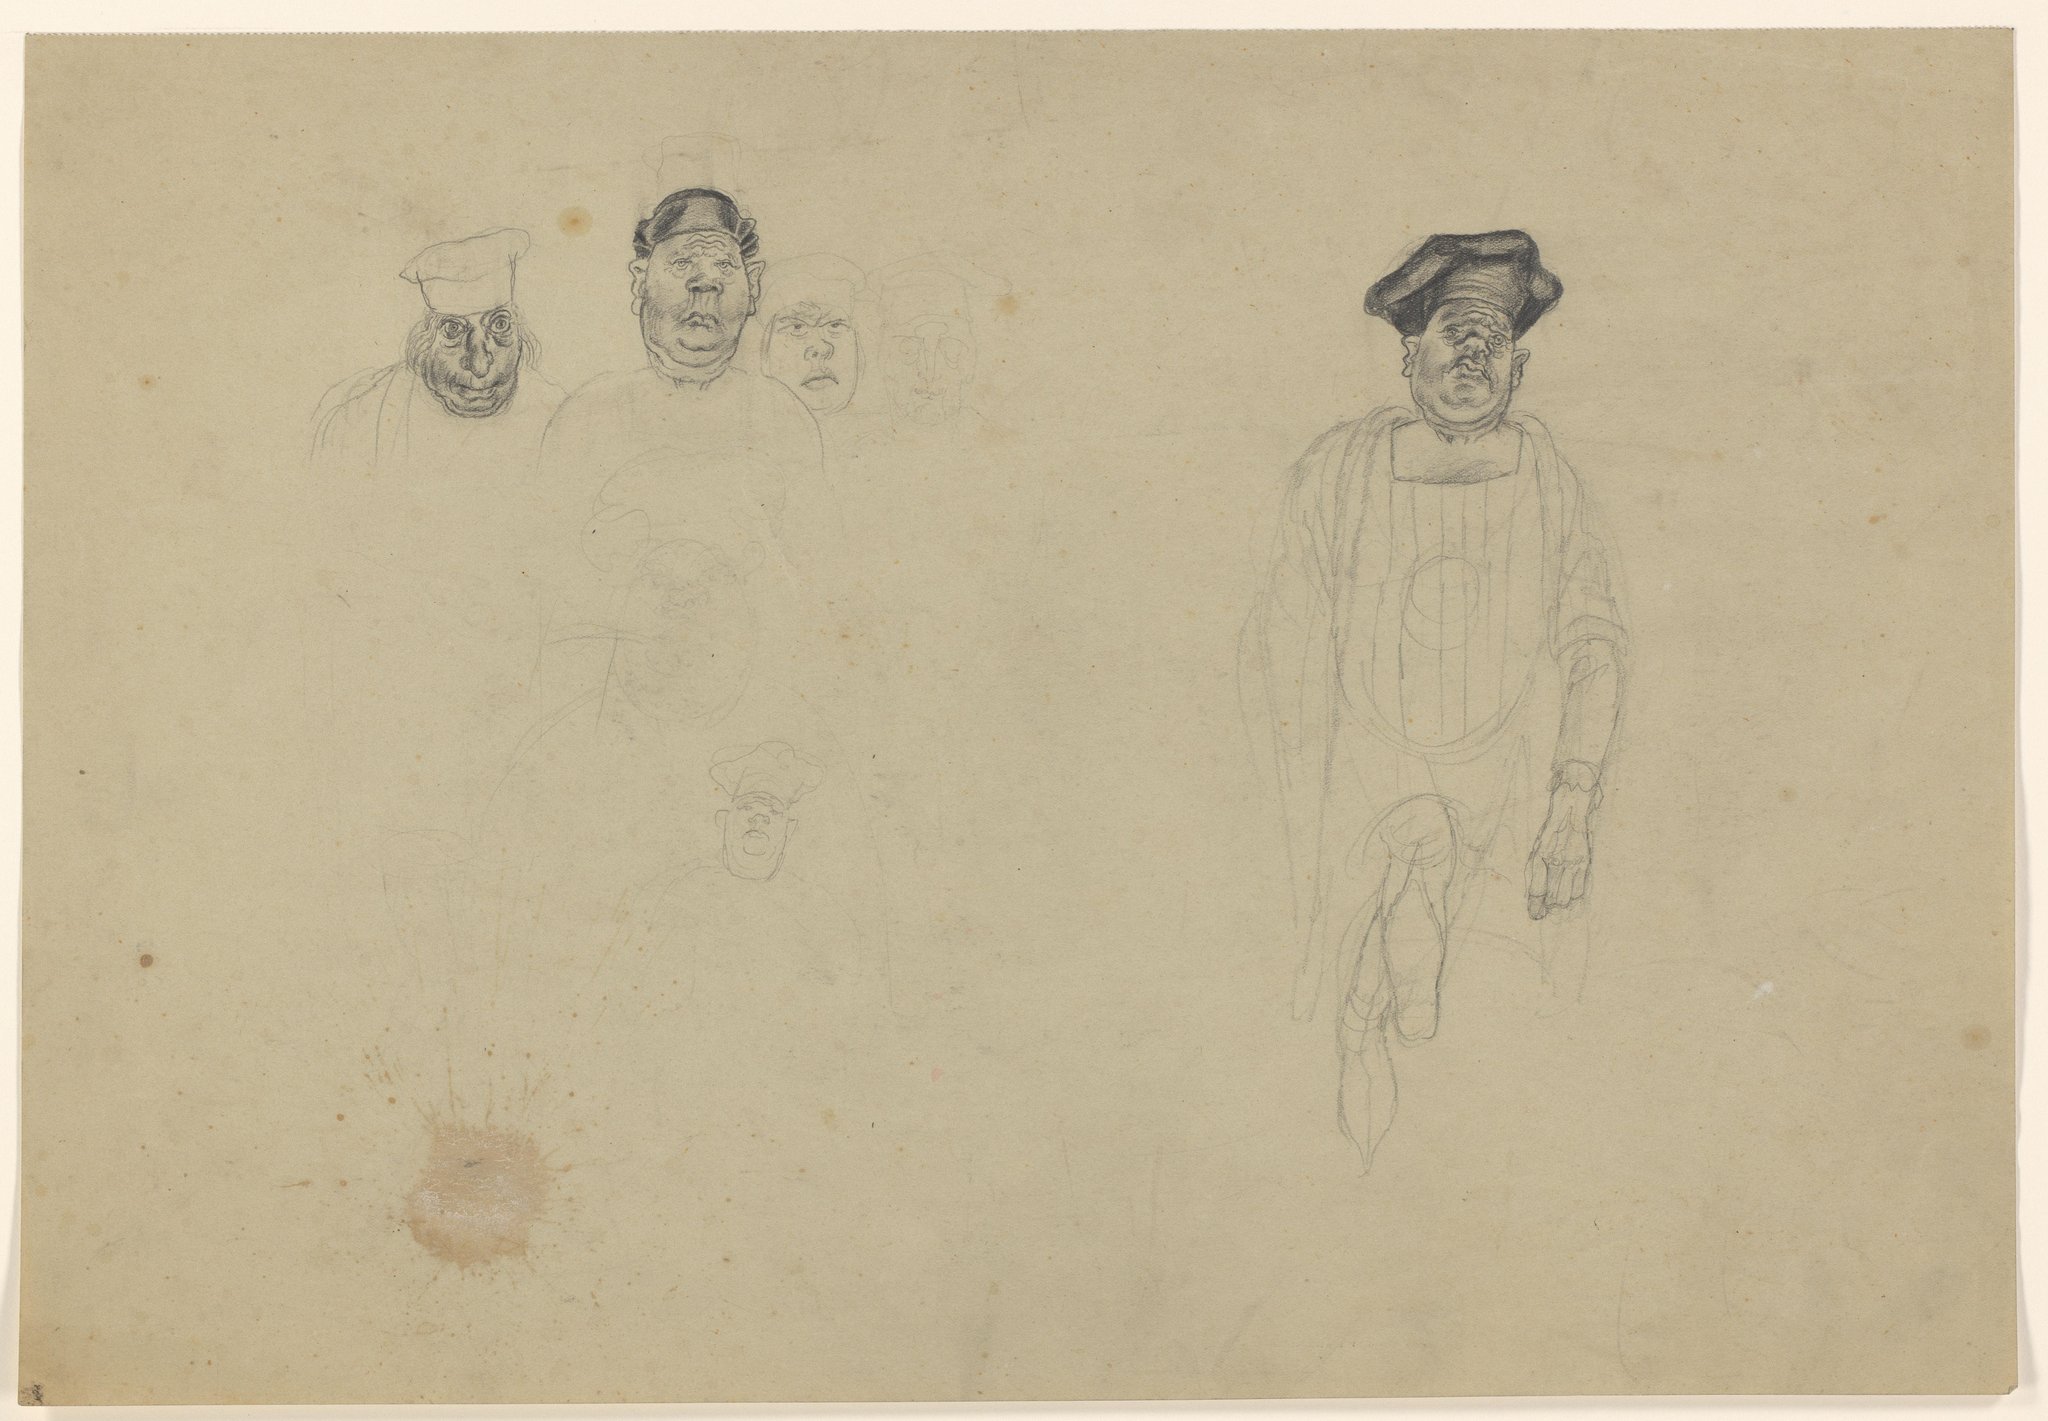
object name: drawing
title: Verschillende figuren met hoeden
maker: henk henriët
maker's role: draughtsman, print maker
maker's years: 1903-1945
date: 1936-1940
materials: paper, pencil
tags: head-gear, caricatures (human types)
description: Deze tekening is mogelijk een ontwerp voor een illustratie bij het boek 'Gargantua en Pantagruel' van François Rabelais.